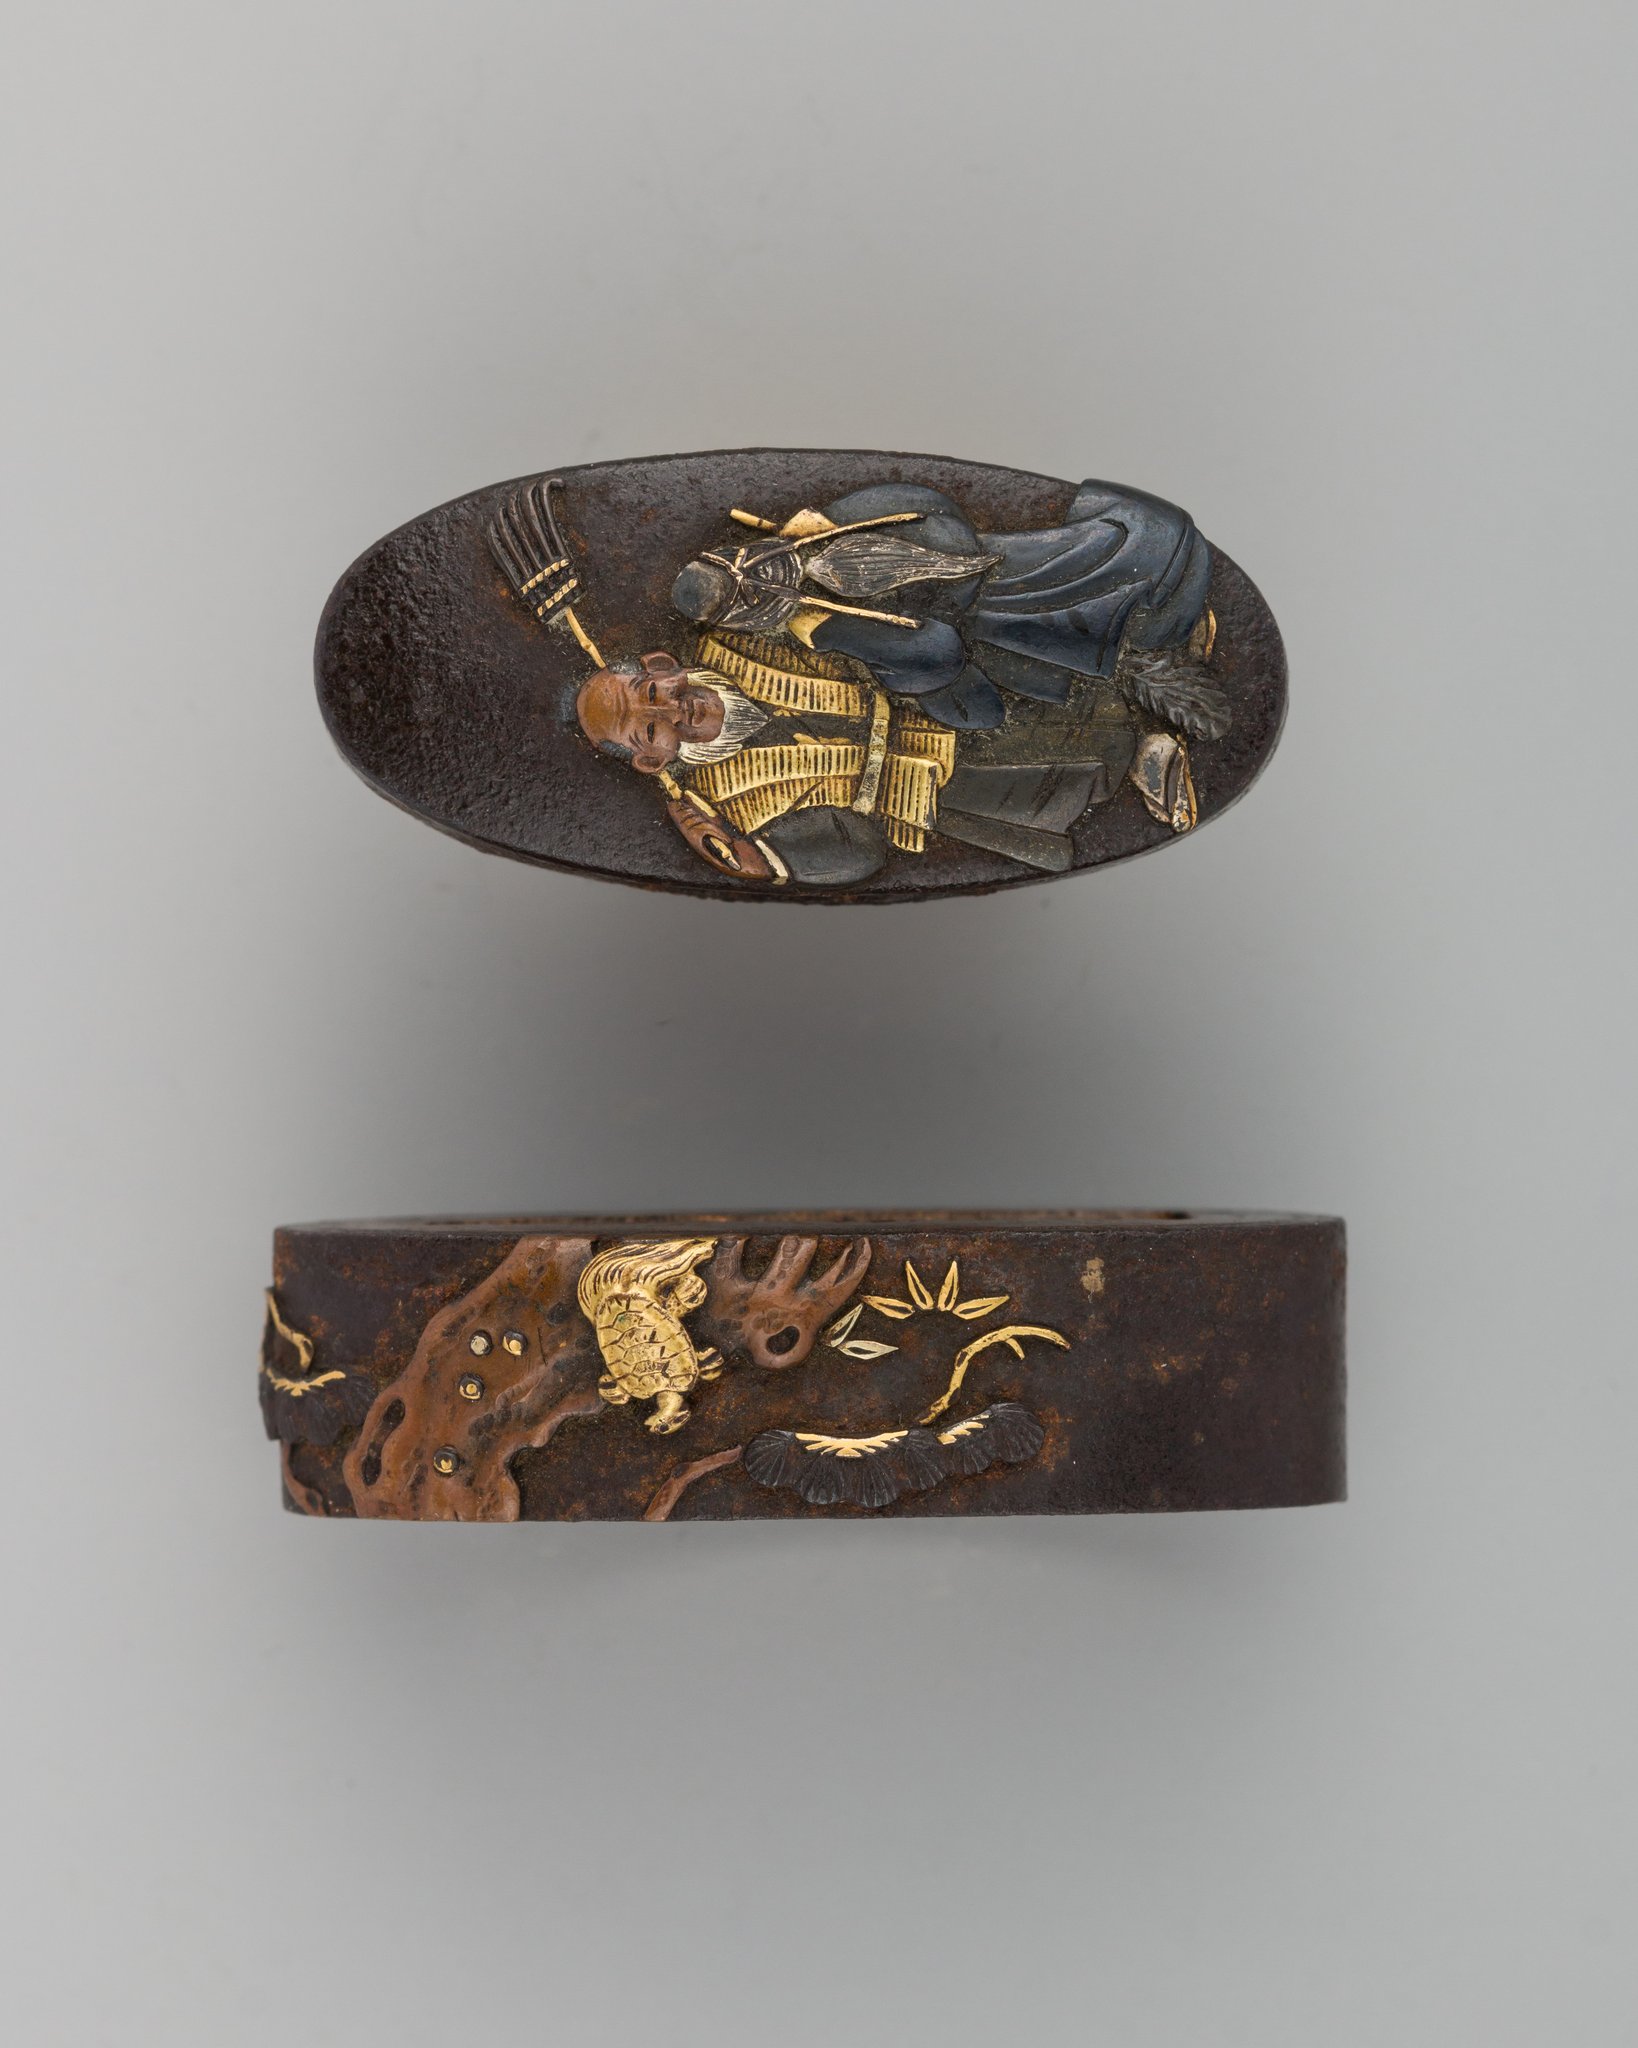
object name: sword hilt collar and pommel fuchigashira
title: Sword-Hilt Collar and Pommel (Fuchigashira)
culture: japanese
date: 1615-1868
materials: copper, gold alloy, gold, iron, silver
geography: japan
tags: animals,men